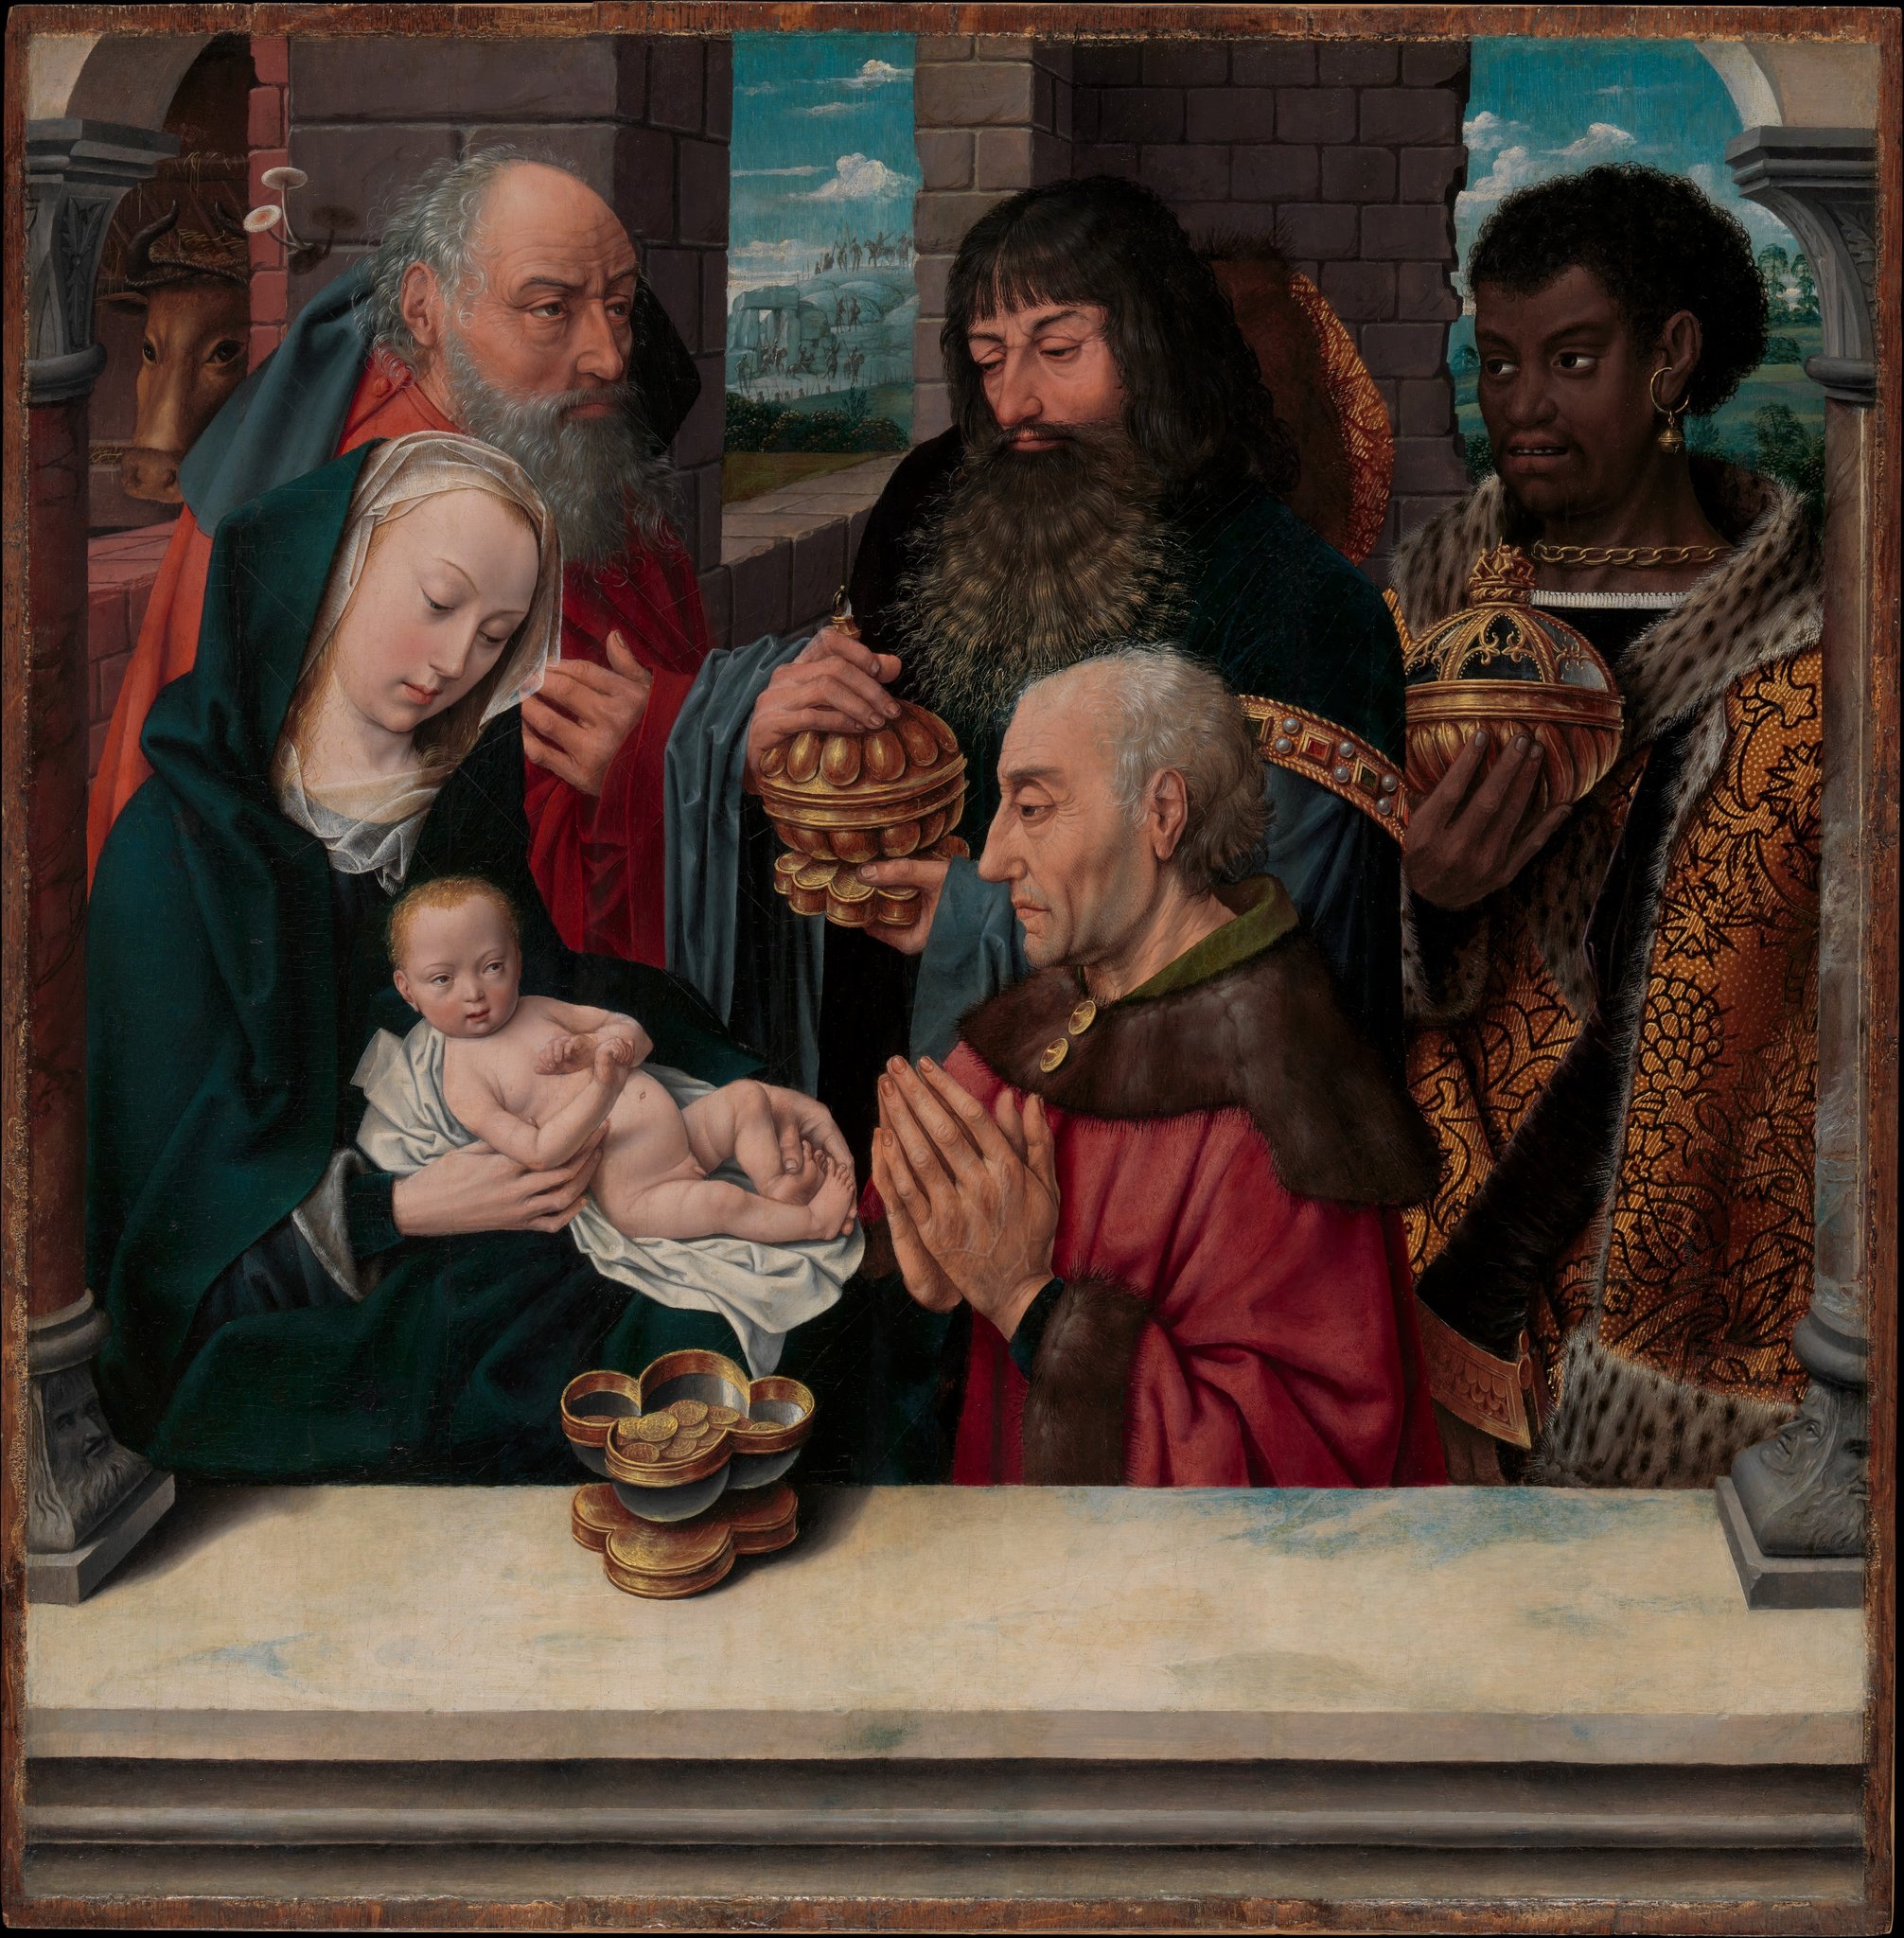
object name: painting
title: The Adoration of the Magi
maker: hugo van der goes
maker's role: artist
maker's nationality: netherlandish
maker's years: 1467-1482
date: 1470-1499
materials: oil, wood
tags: men,virgin mary,jesus,adoration of the magi,saints